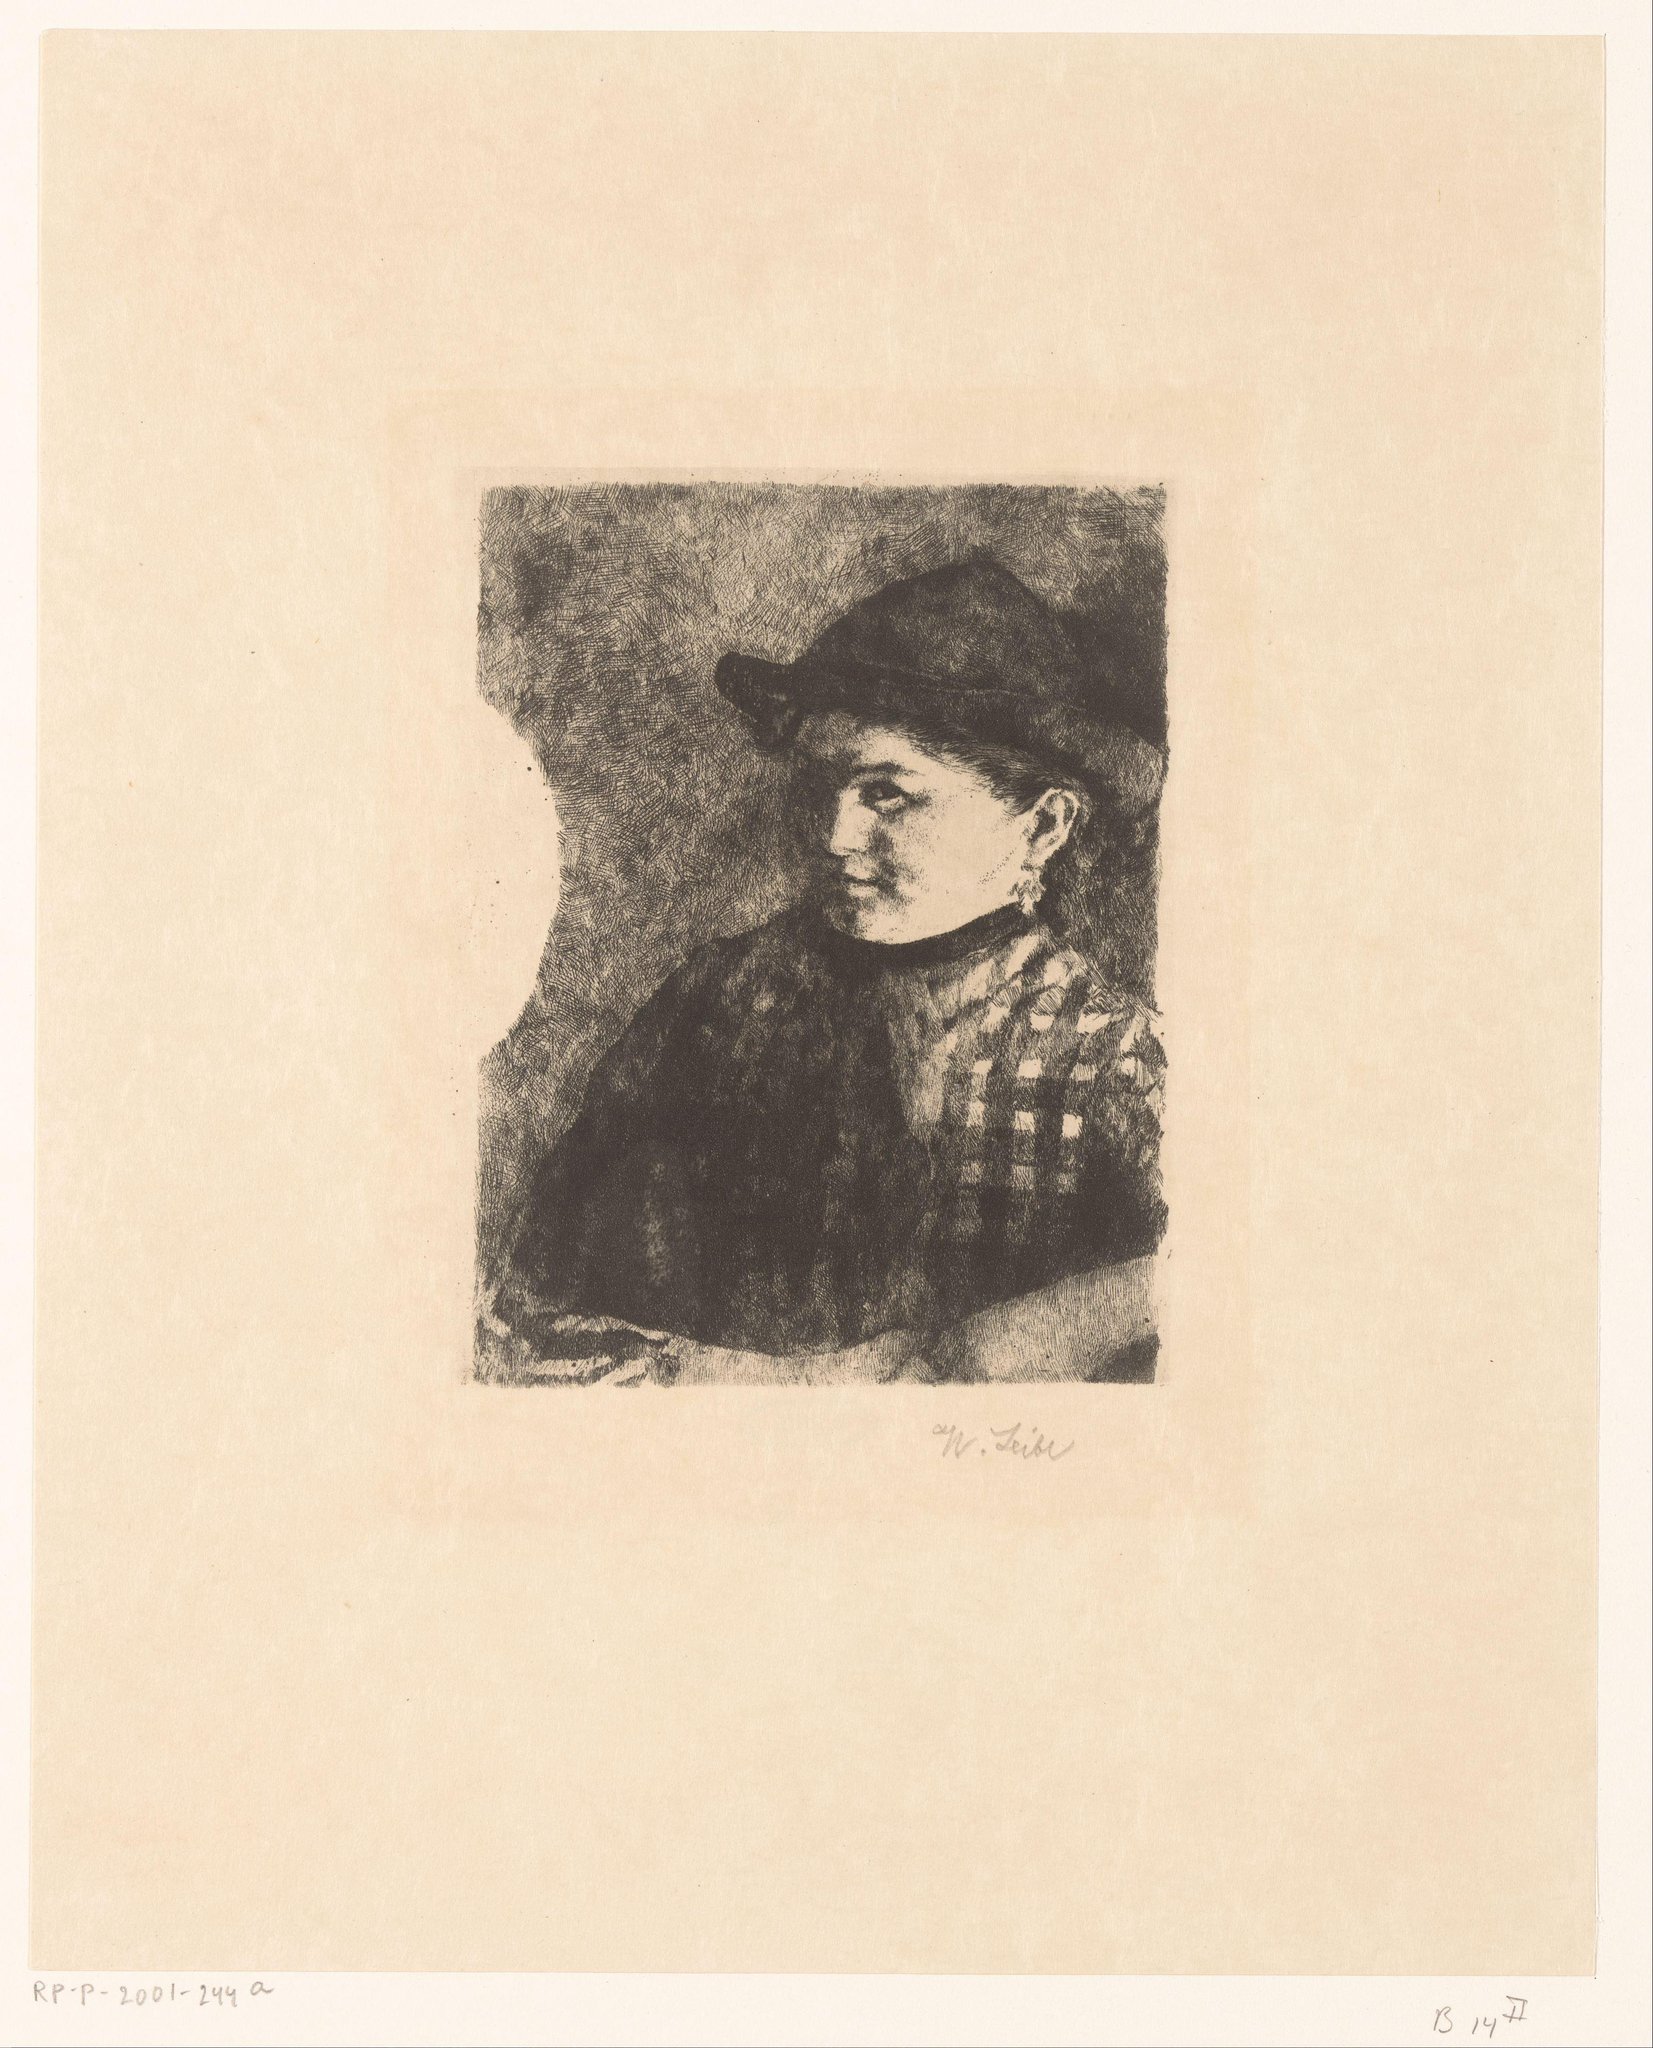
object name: print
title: Boerenmeisje met hoed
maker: wilhelm maria hubertus leibl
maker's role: print maker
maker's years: 1844-1900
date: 1875-1877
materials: paper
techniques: etching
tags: adolescent, young woman, maiden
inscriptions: collector's mark: Lugt 2760, collector's mark: Lugt 2228